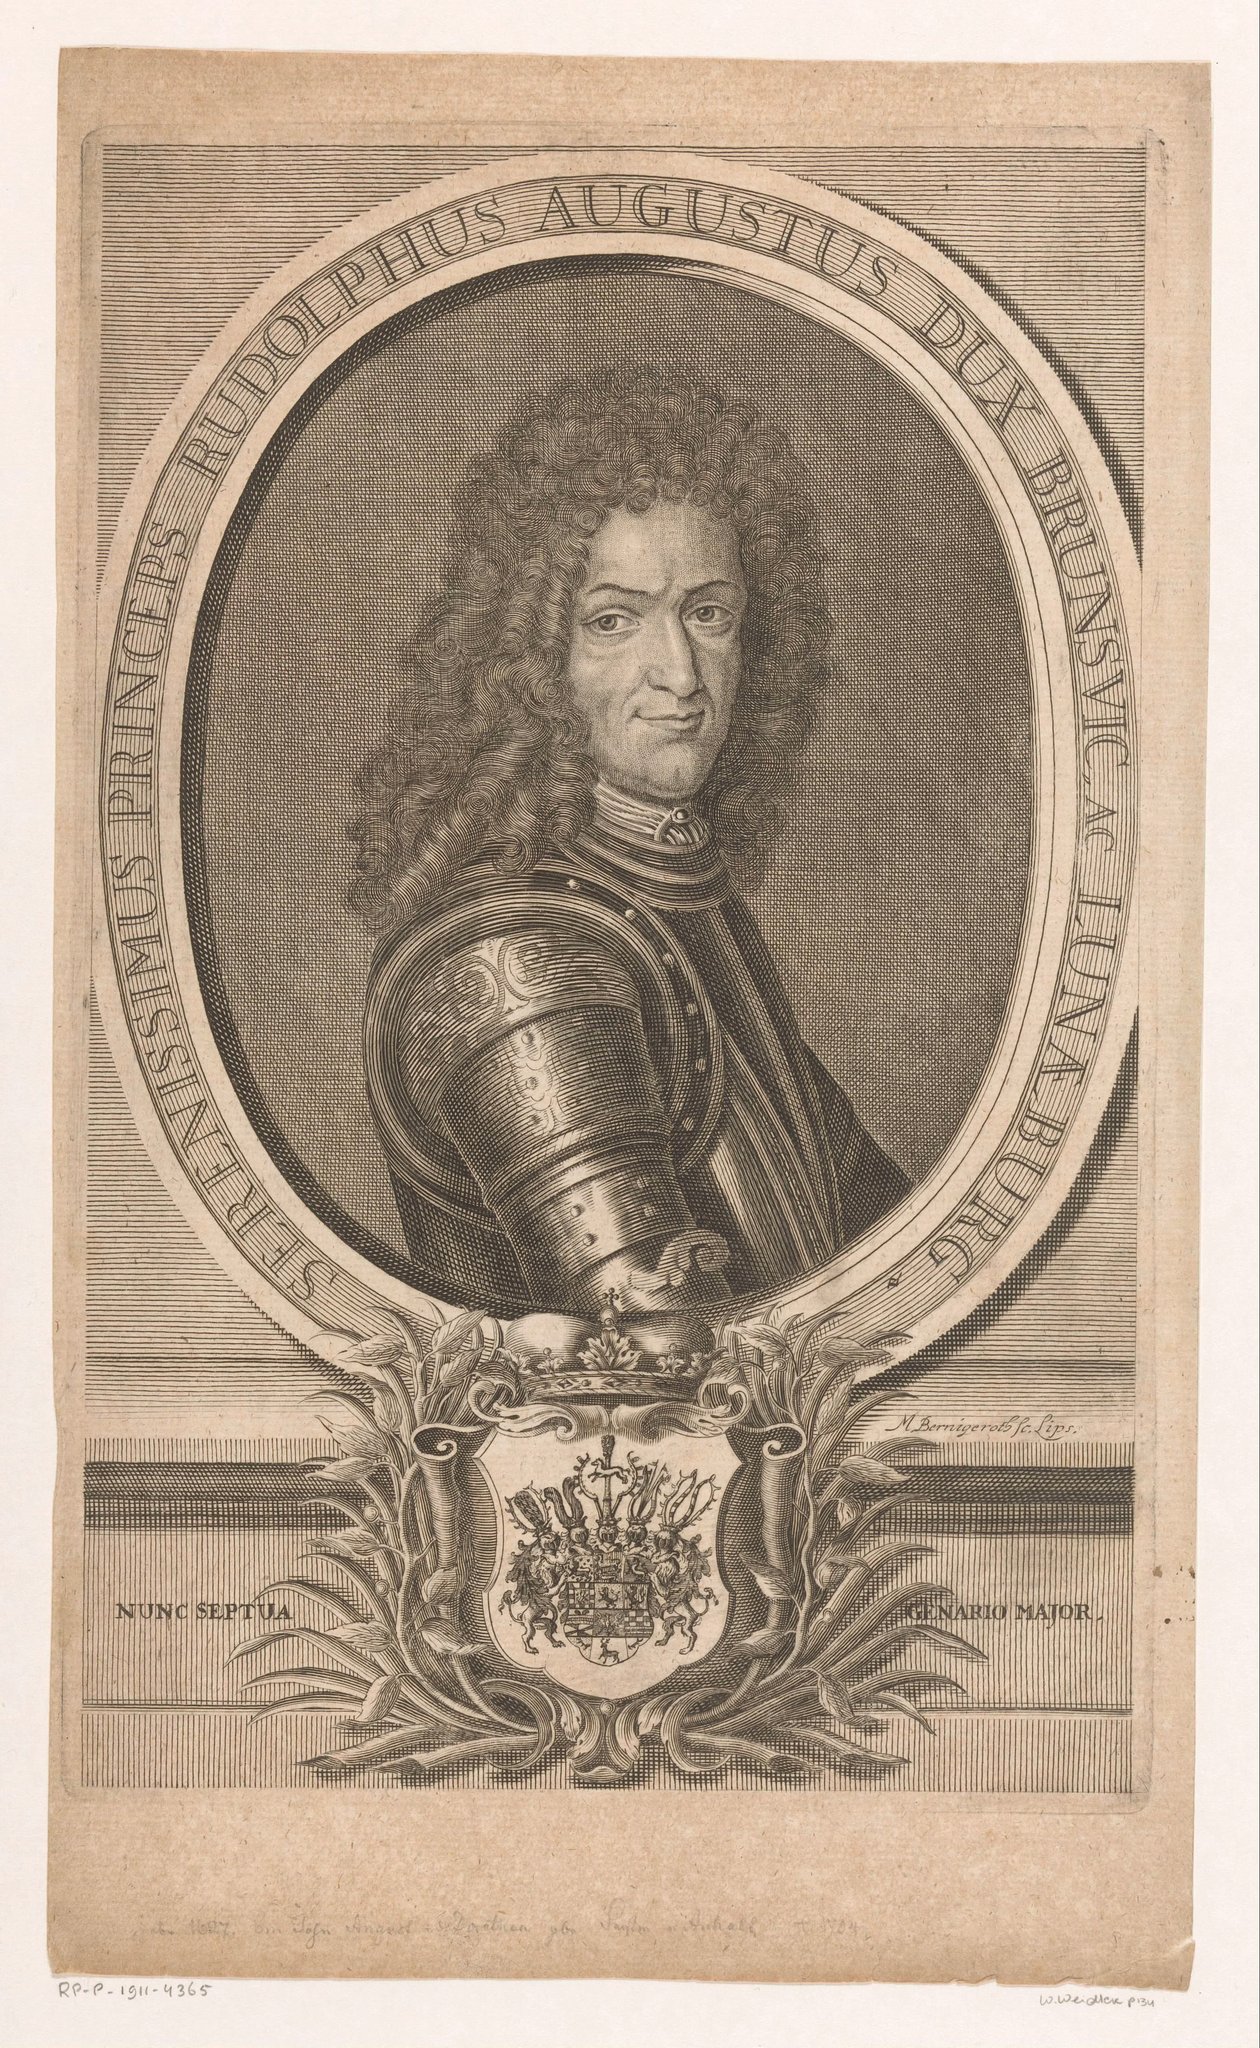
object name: print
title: Portret van Rudolf August von Braunschweig-Wolfenbüttel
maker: martin bernigeroth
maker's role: print maker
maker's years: 1670-1733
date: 1680-1733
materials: paper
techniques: engraving, etching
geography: leipzig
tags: armour, historical persons, armorial bearing, heraldry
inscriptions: collector's mark: Lugt 2228